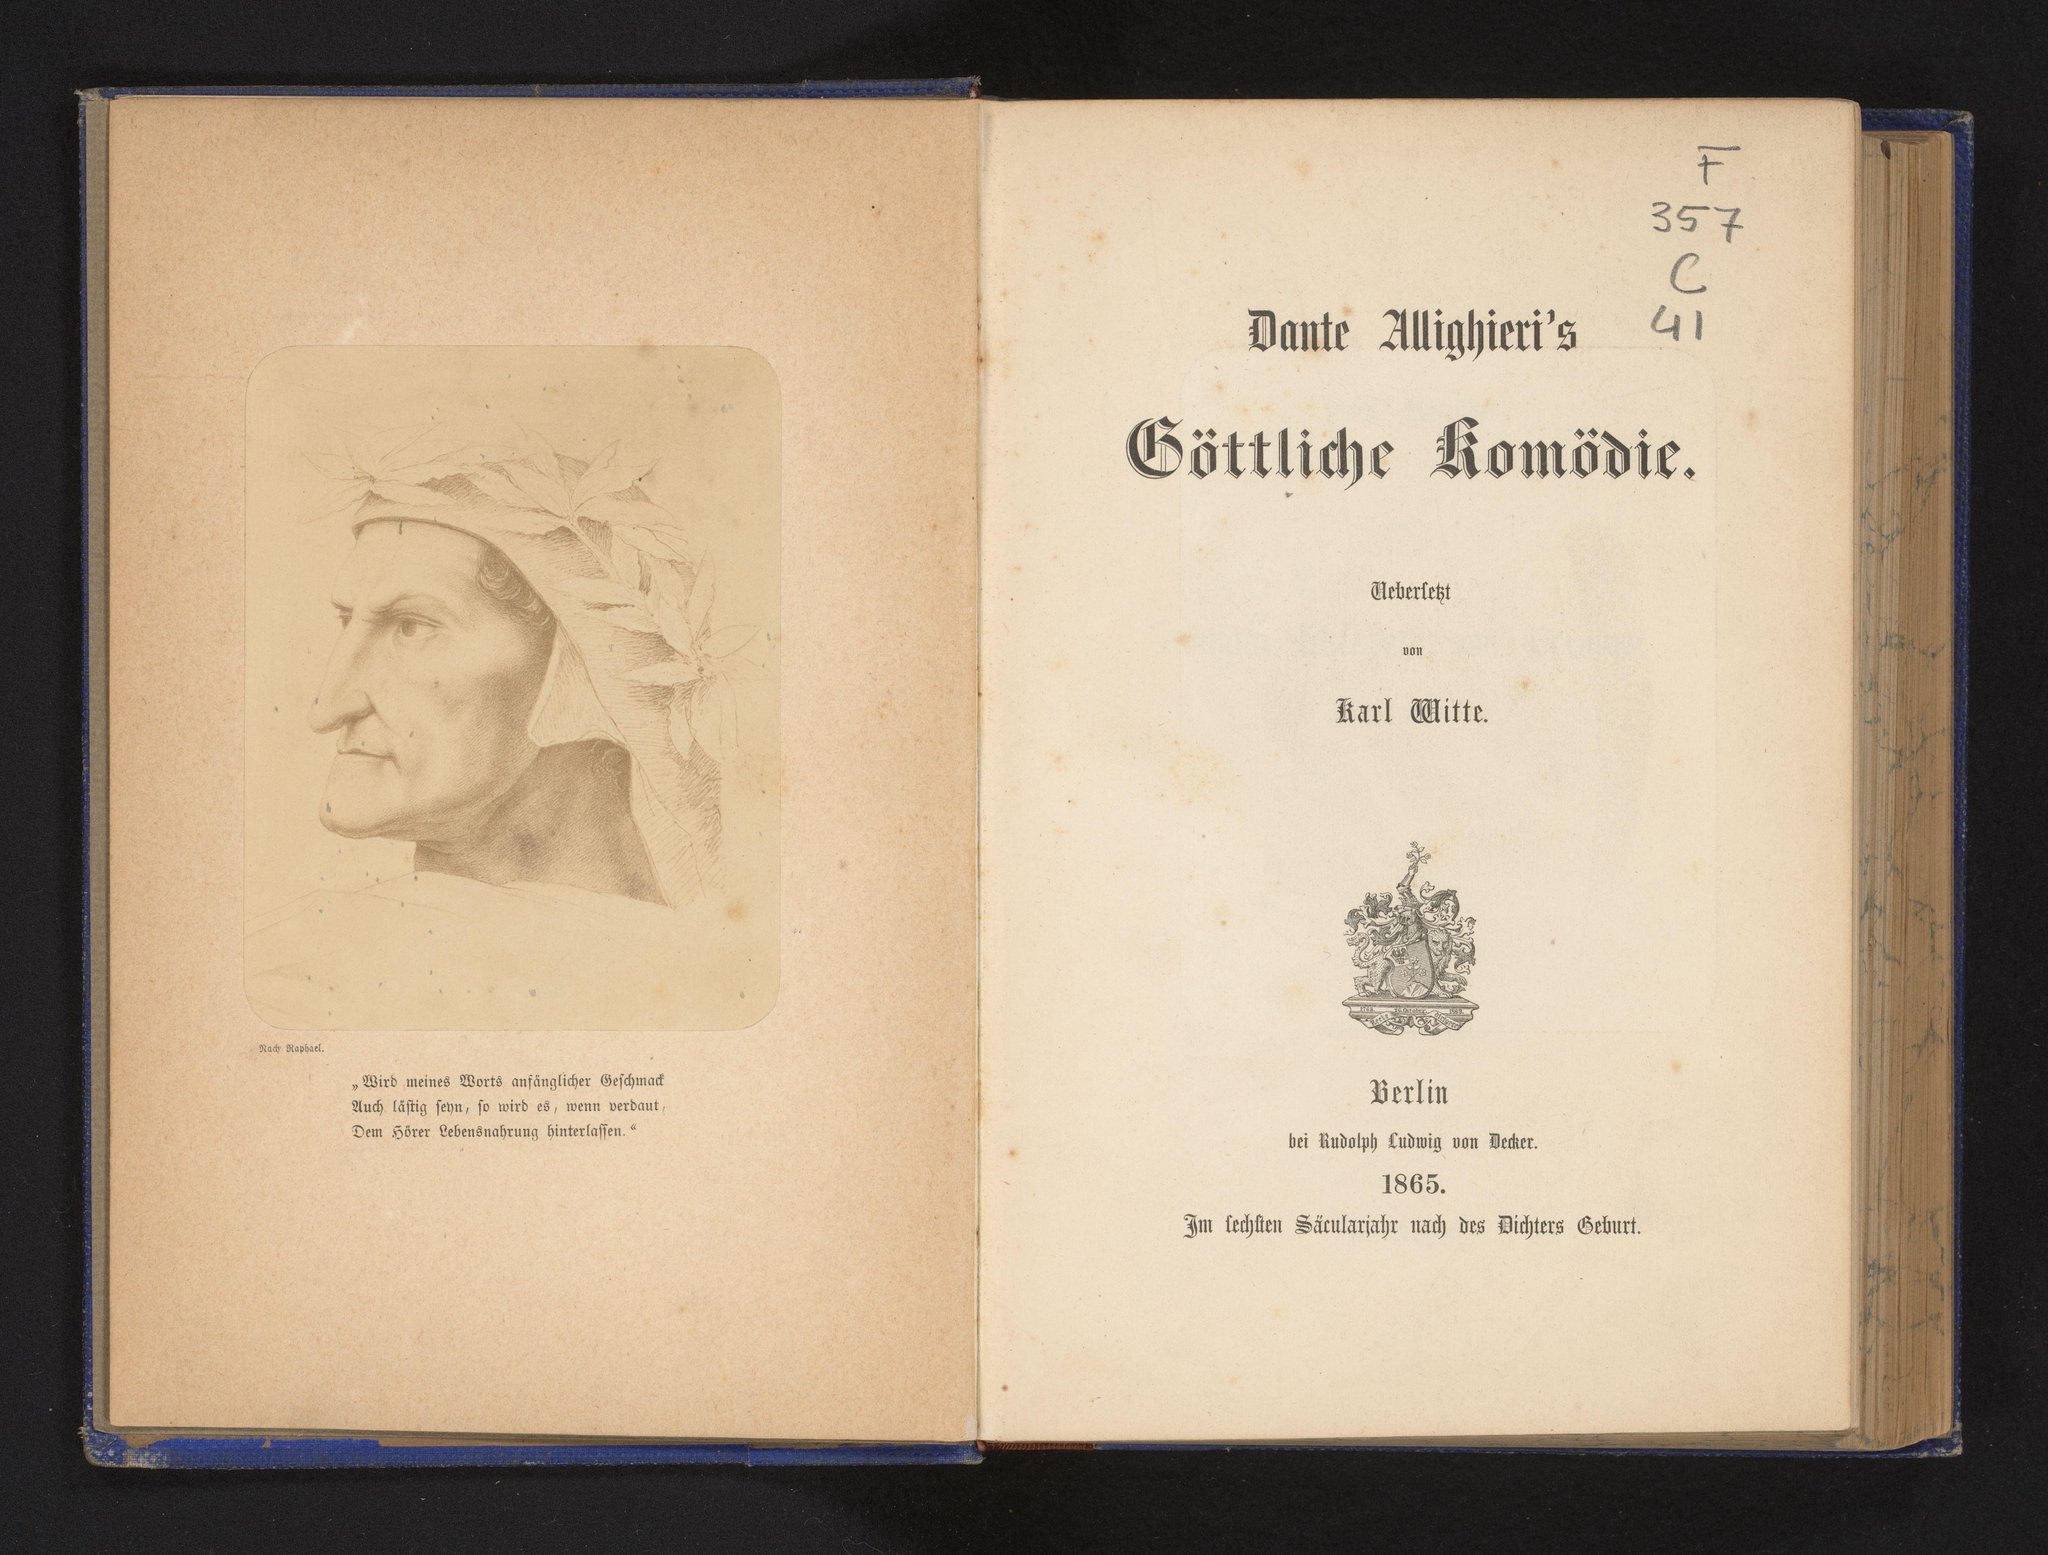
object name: book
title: Dante Allighieri's göttliche Komödie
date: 1865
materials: cardboard, linen, paper, photographic support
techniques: albumen print, printing